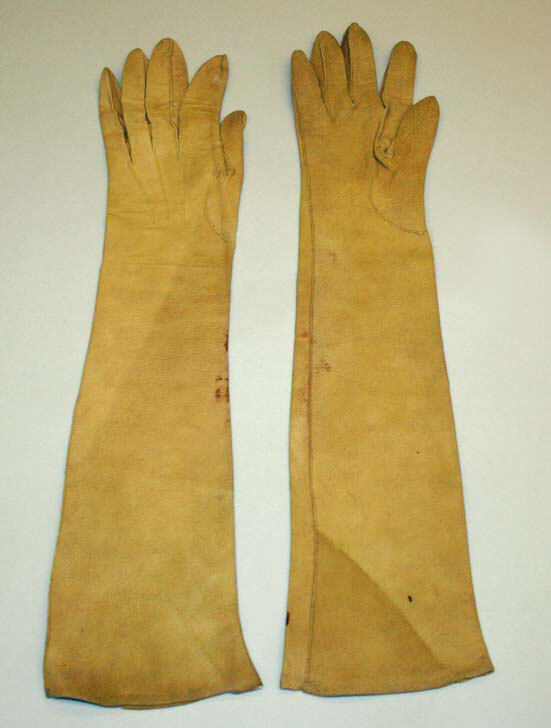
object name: glove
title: Gloves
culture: italian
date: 1767-1800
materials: leather